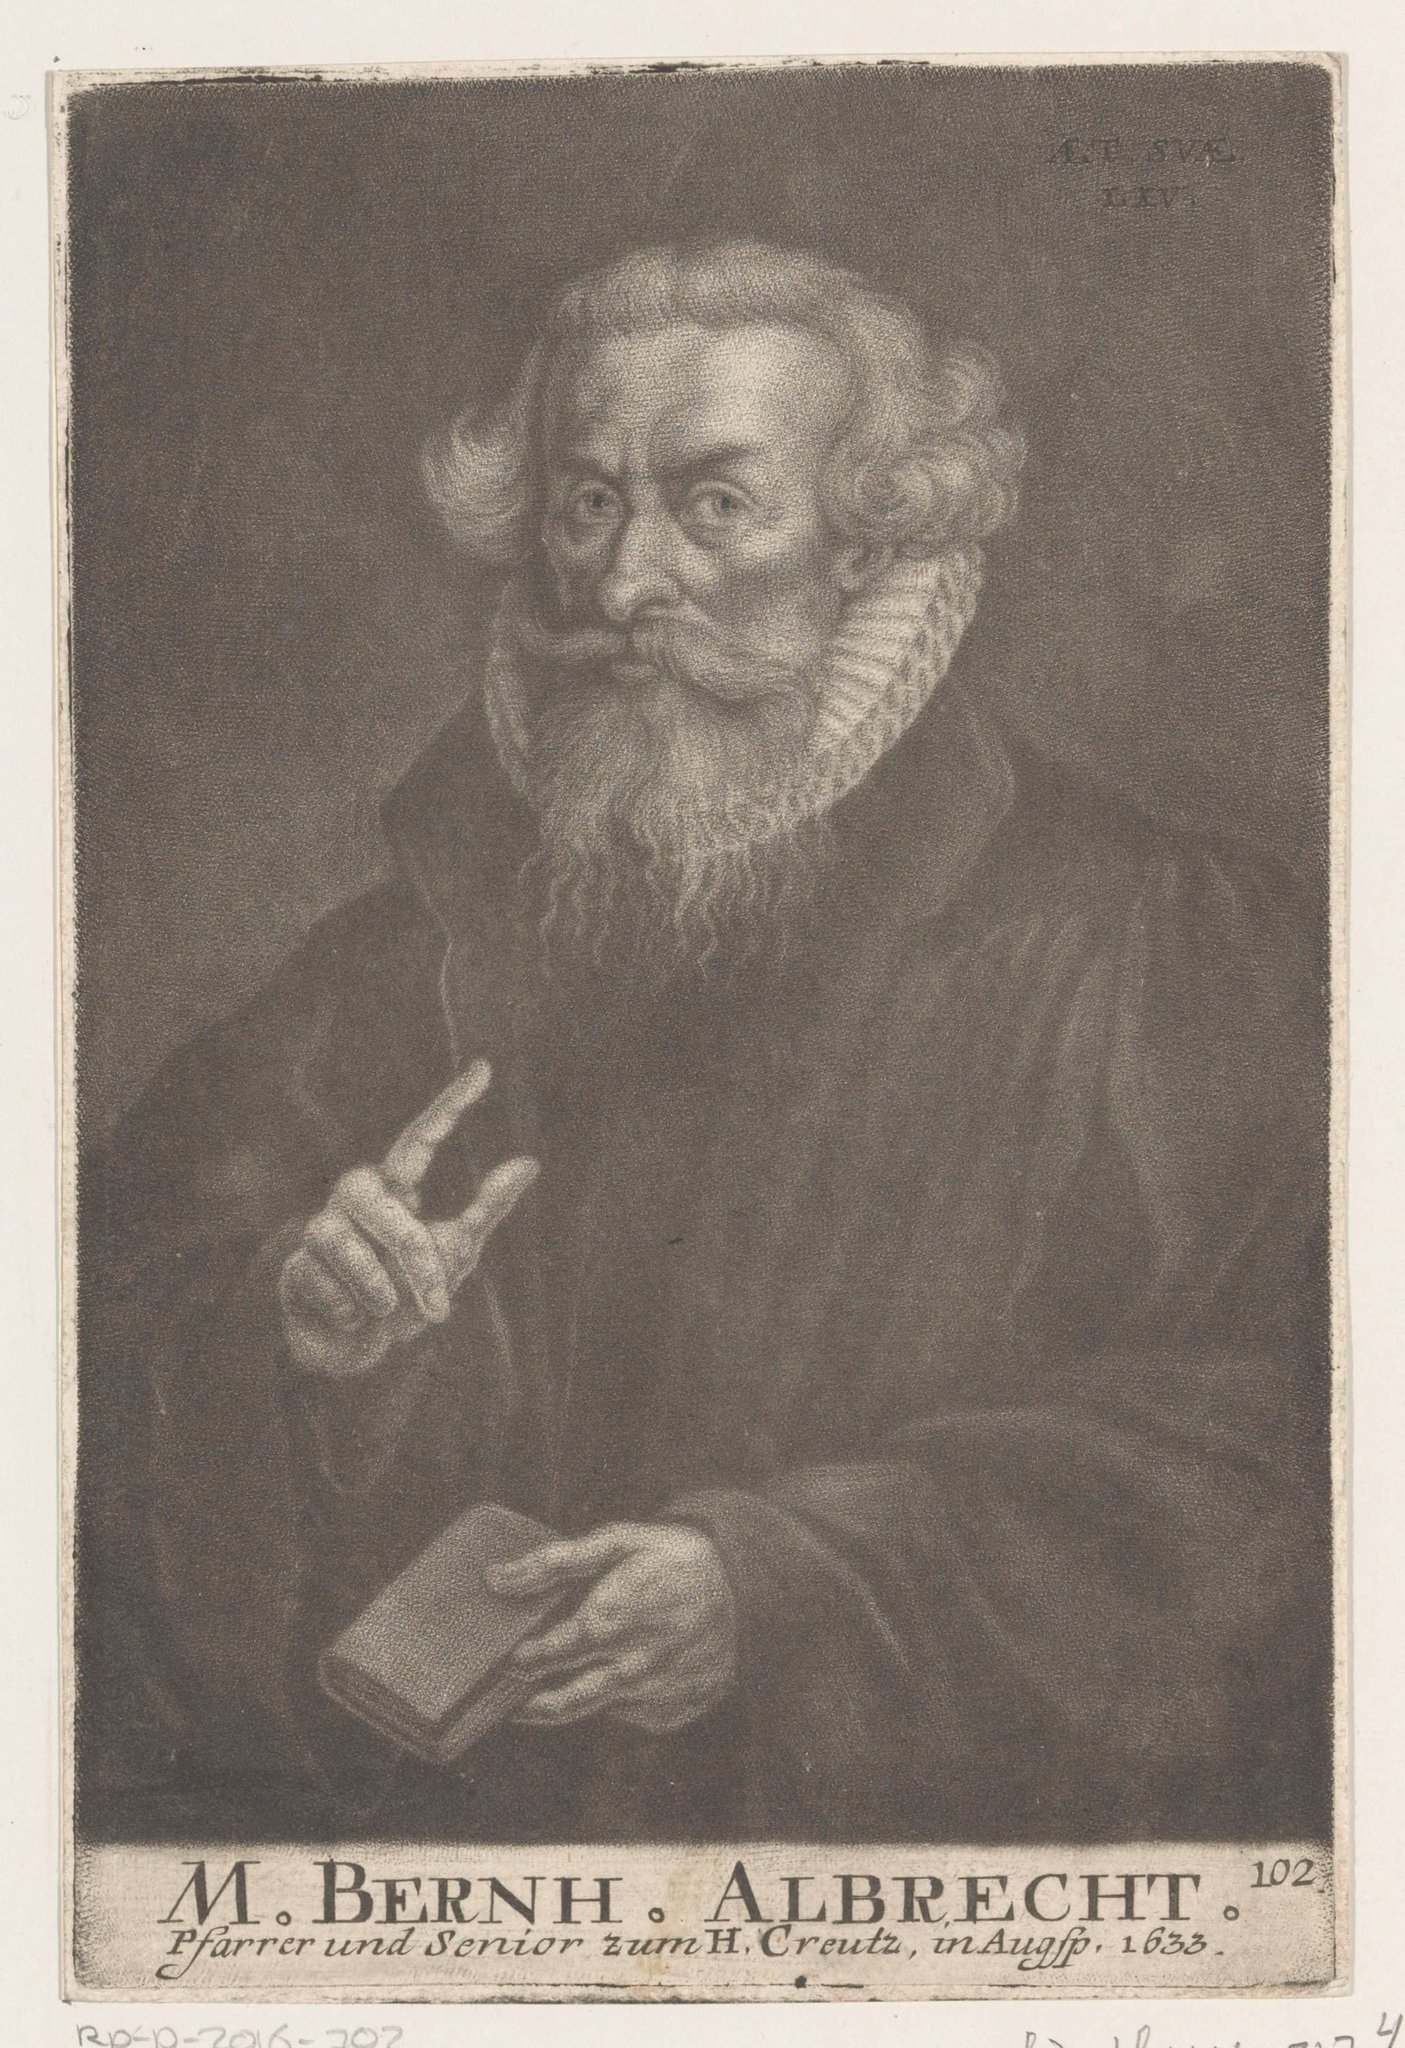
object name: print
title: Portret van Bernhard Albrecht op 65-jarige leeftijd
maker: Anonymous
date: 1642-1699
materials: paper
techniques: mezzotint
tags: augsburg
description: Portret van Bernhard Albrecht. Hij heeft een boek in zijn linkerhand. Rechtsboven zijn leeftijd. In de ondermarge zijn naam en een regel Duitse tekst. Rechtsonder: 102.